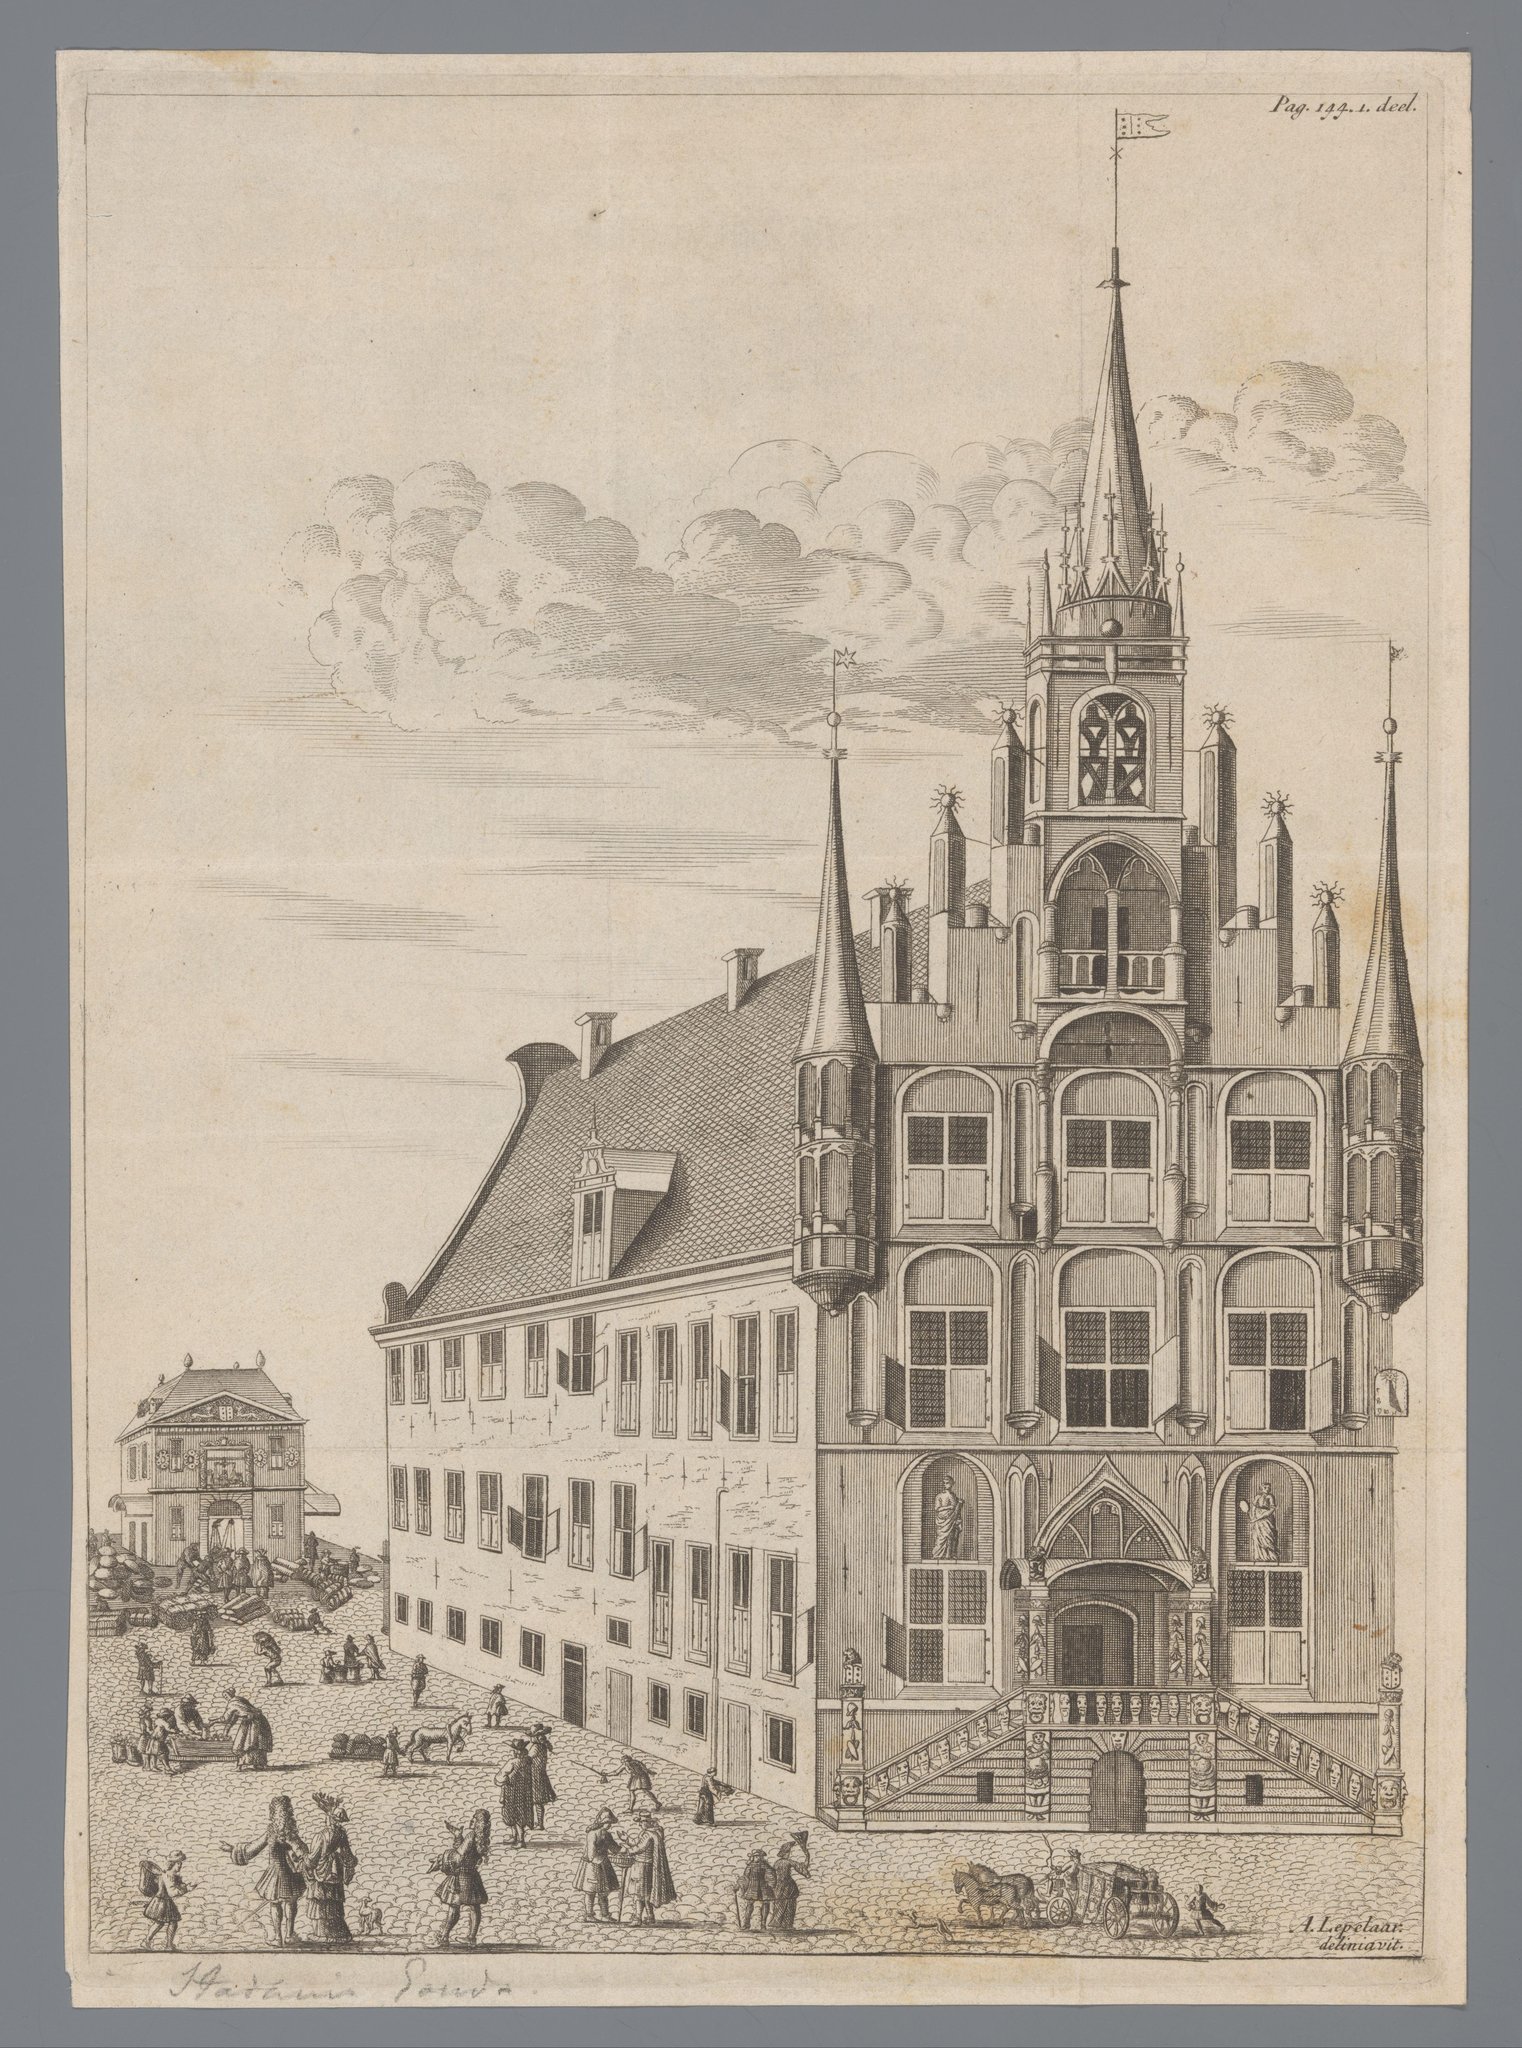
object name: book illustration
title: Gezicht op het Stadhuis van Gouda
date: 1713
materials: paper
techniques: etching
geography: gouda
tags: townhall, square, place, circus, etc. (+ city(-scape) with figures, staffage)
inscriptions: collector's mark: Lugt 2228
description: Prent uit: Walvis, J. Beschryving der Stad Gouda (...). Gouda: Johannes en Andries Endenburg, Leiden: Christiaen Vermey, 1713, dl. 1, p. 144.